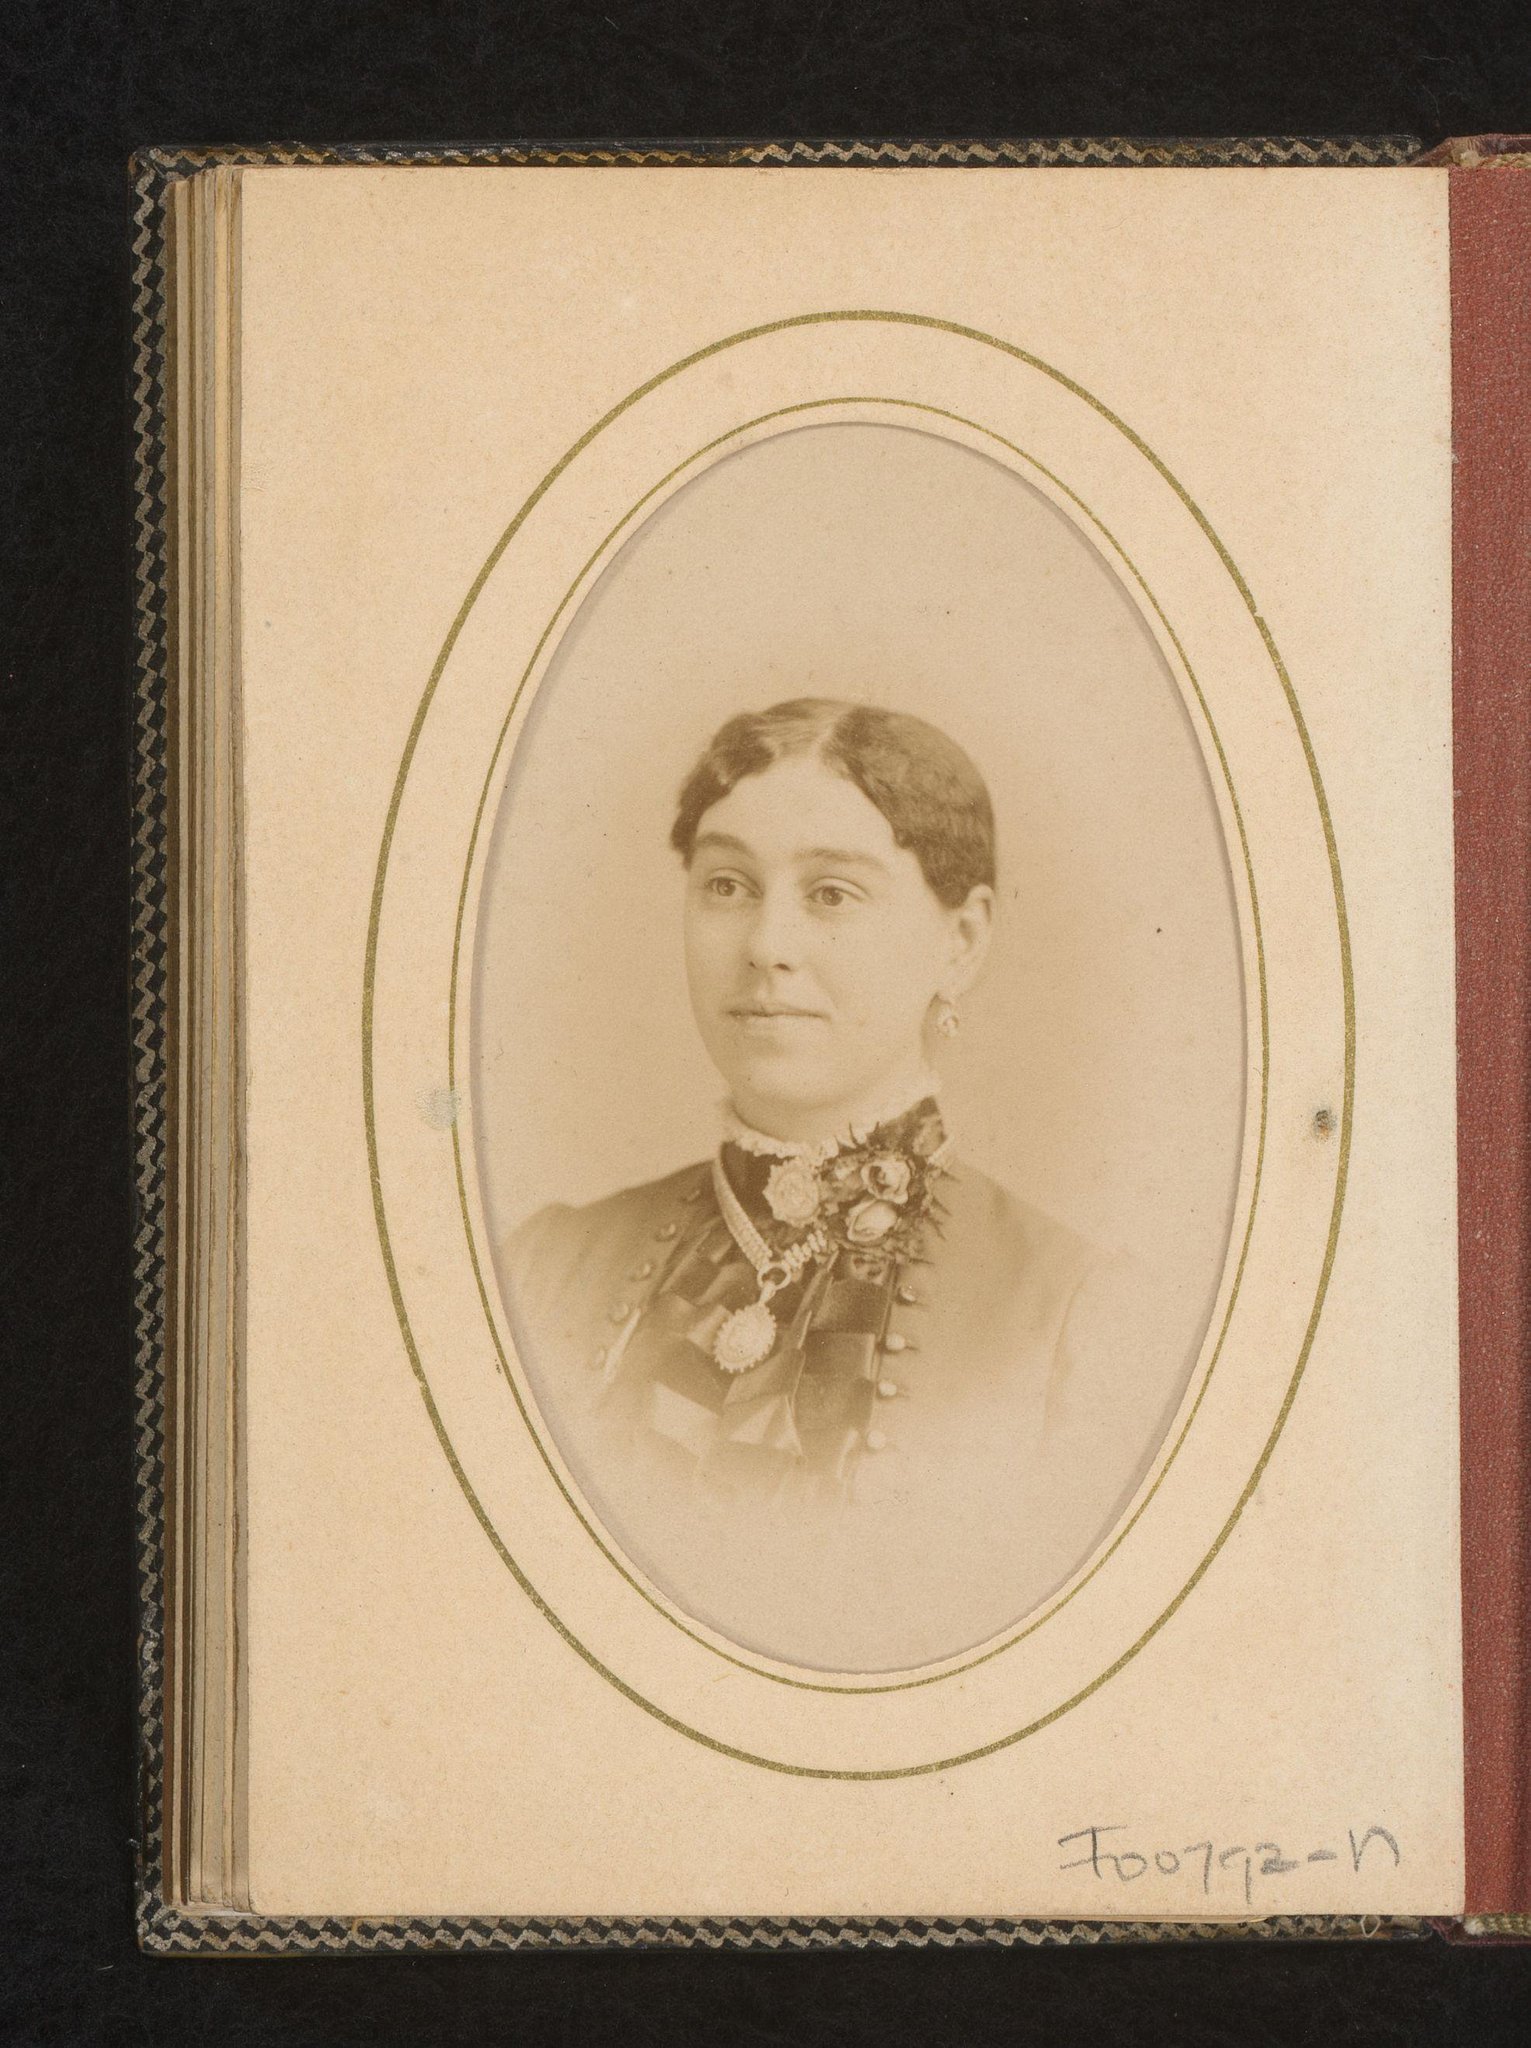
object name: album leaf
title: Portret van een vrouw met ketting, oorbellen en broches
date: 1876-1911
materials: cardboard, photographic support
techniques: albumen print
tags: adult woman, historical persons, brooch, agraffe, clasp, necklace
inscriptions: inscription: ‘Photographers to Her Majesty the Queen/ (...)/ 153, Regent Street/ London, W.’